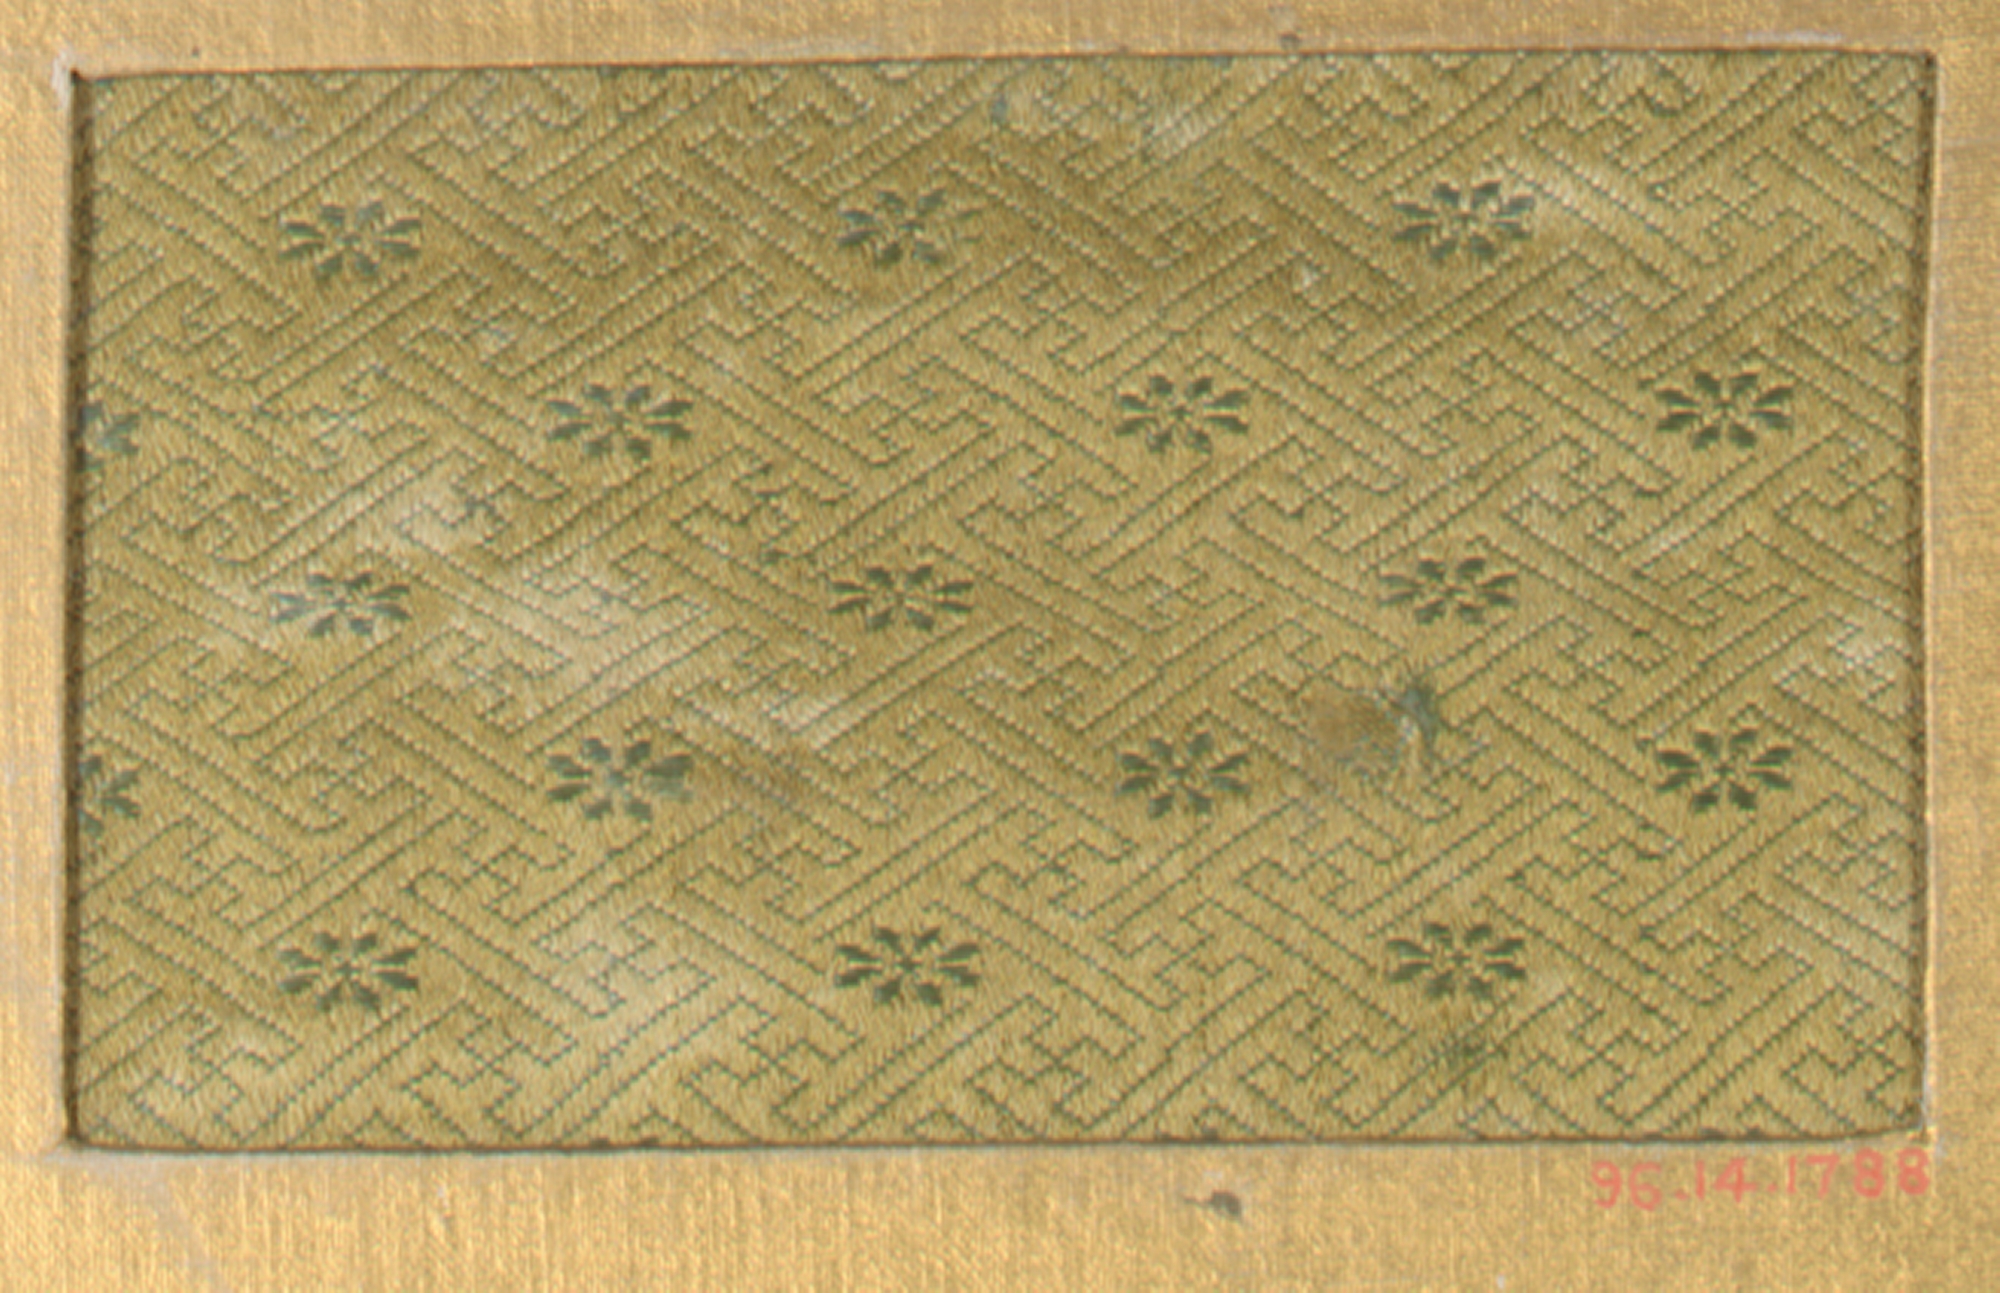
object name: piece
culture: japanese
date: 1701-1900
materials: silk